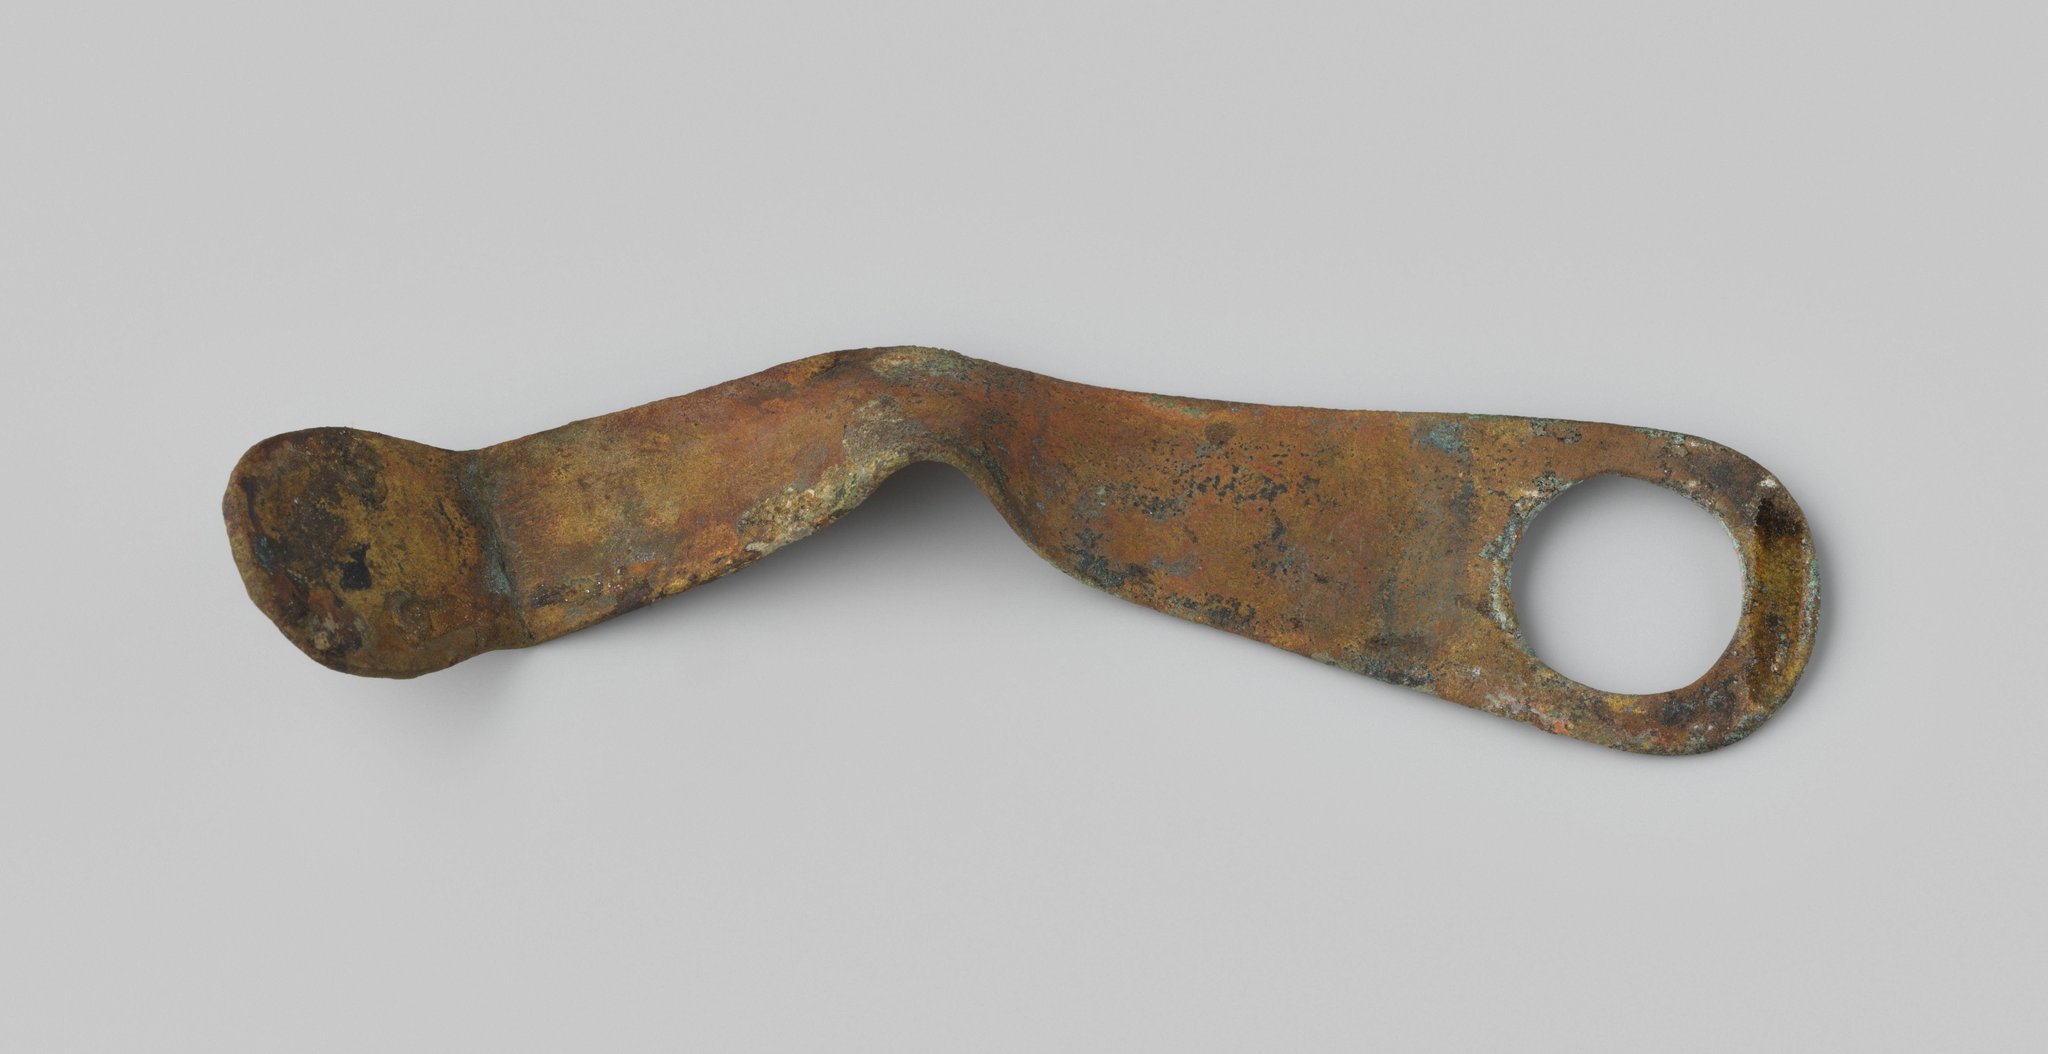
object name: hasp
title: Beugel uit het wrak van de Oost-Indiëvaarder Hollandia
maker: Anonymous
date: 1700-1743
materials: copper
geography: netherlands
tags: verenigde oostindische compagnie, hollandia (schip), annet